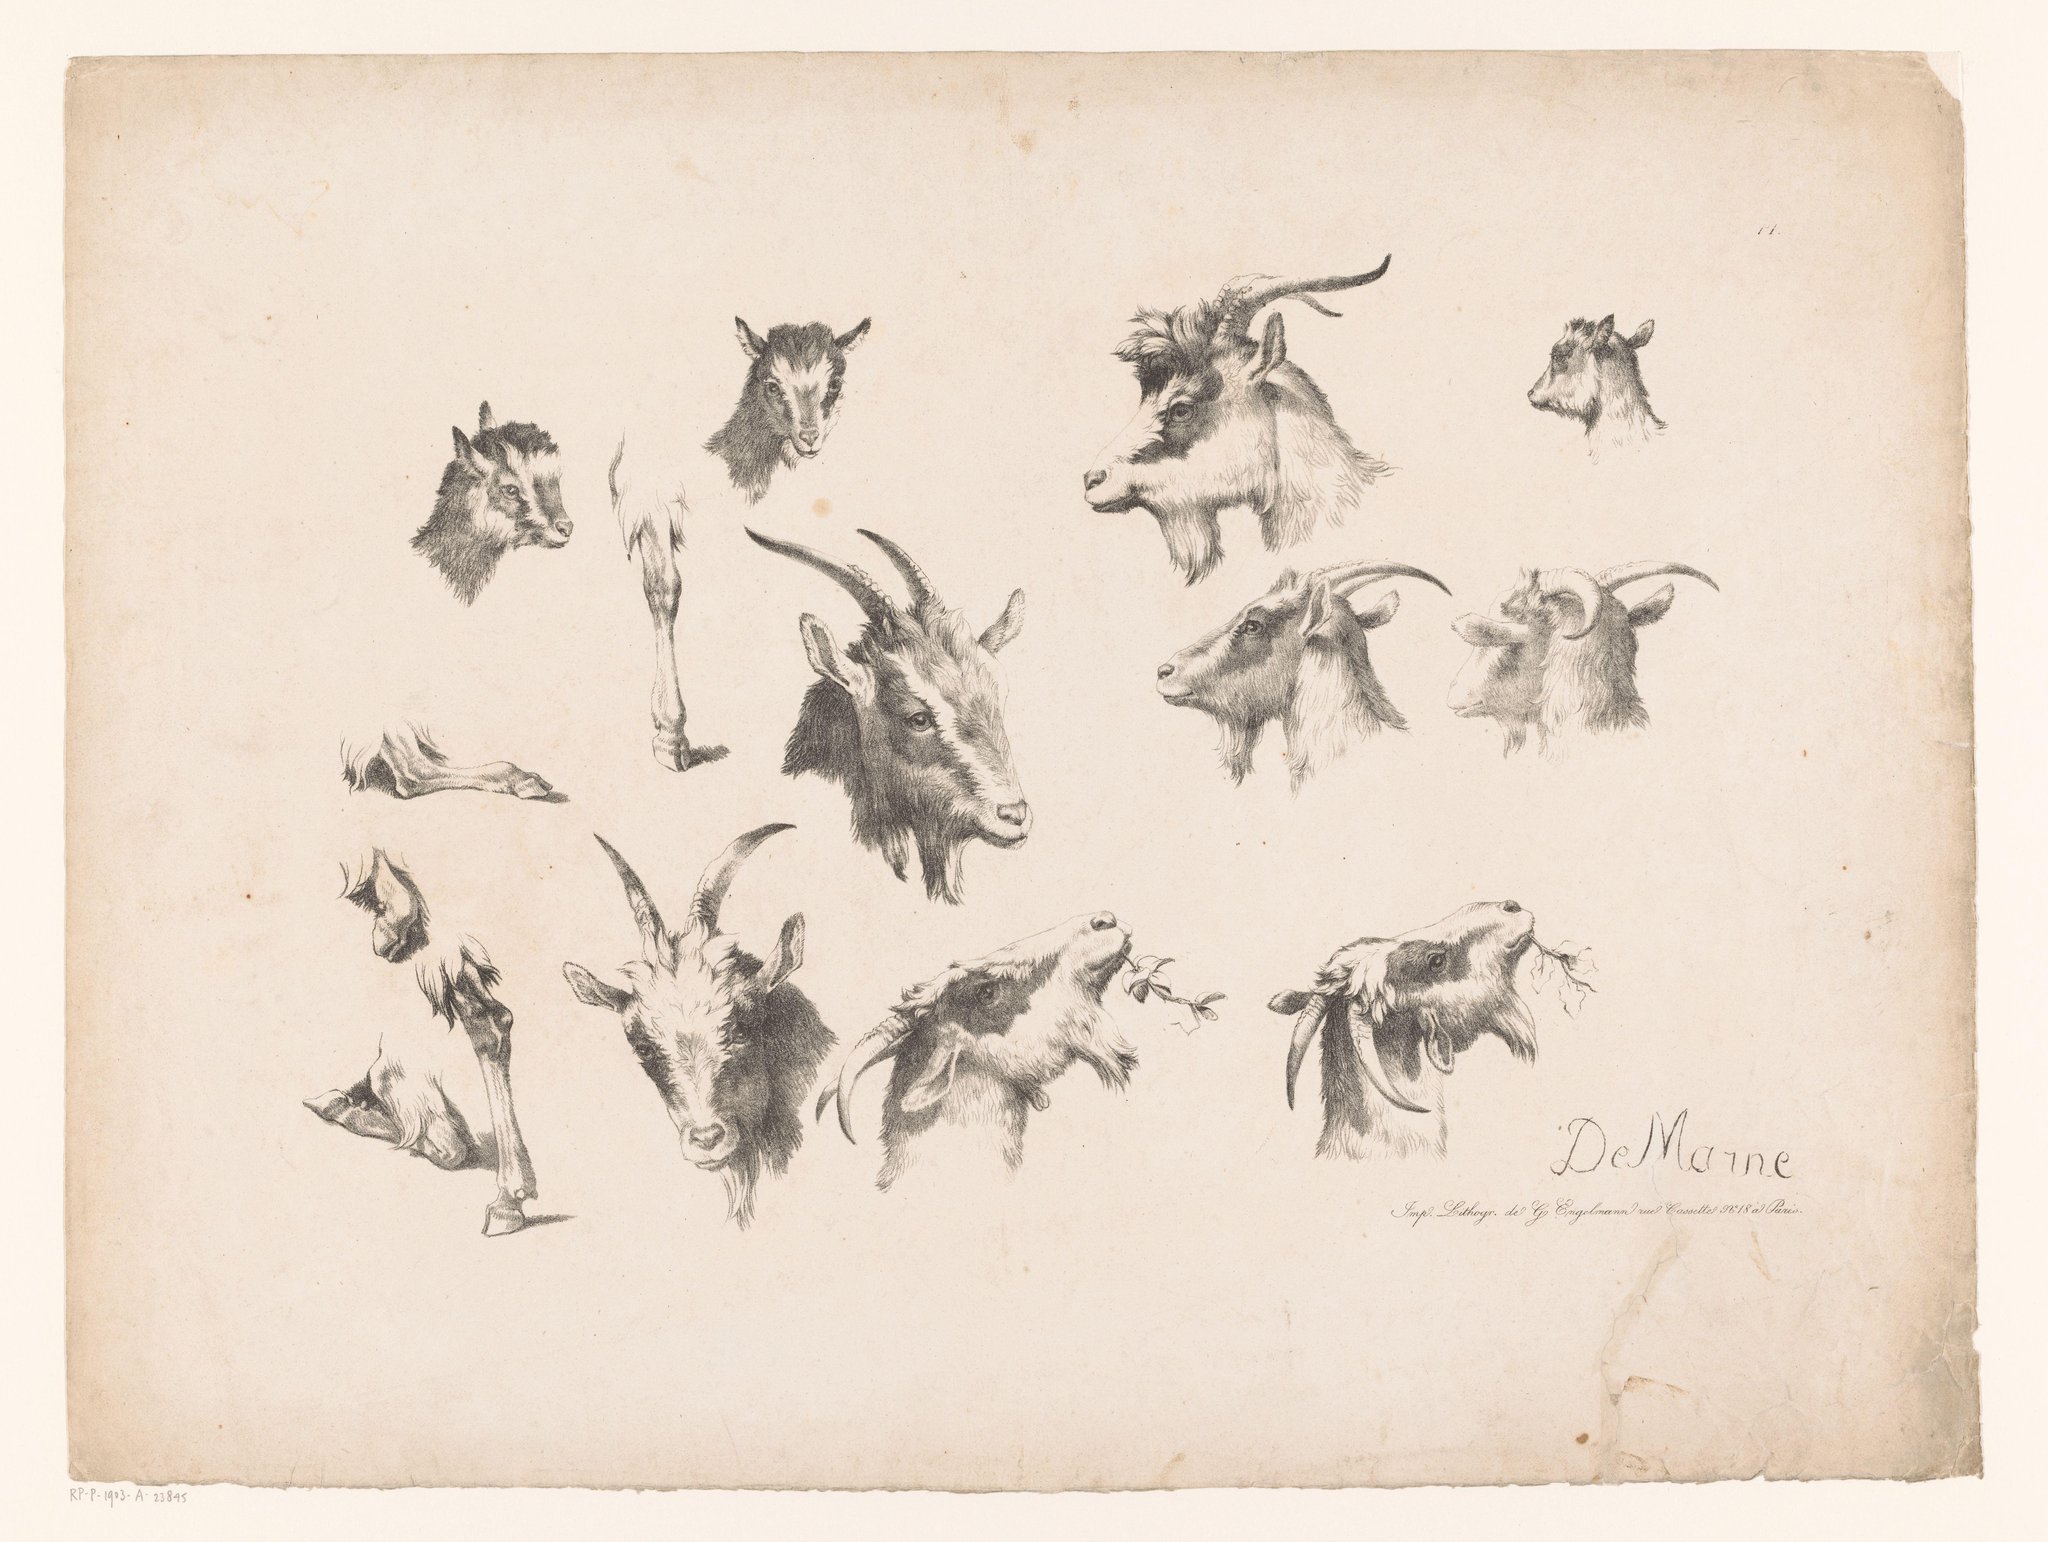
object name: titelprent, frontispice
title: Studies van geiten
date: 1816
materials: paper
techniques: lithograph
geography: paris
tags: goat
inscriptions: collector's mark: Lugt 2228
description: Titelprent van de serie: Demarne, Jean Louis. Cours complet d'études du dessin: animaux I. Études de chevres. Parijs: Engelmann, 1816.